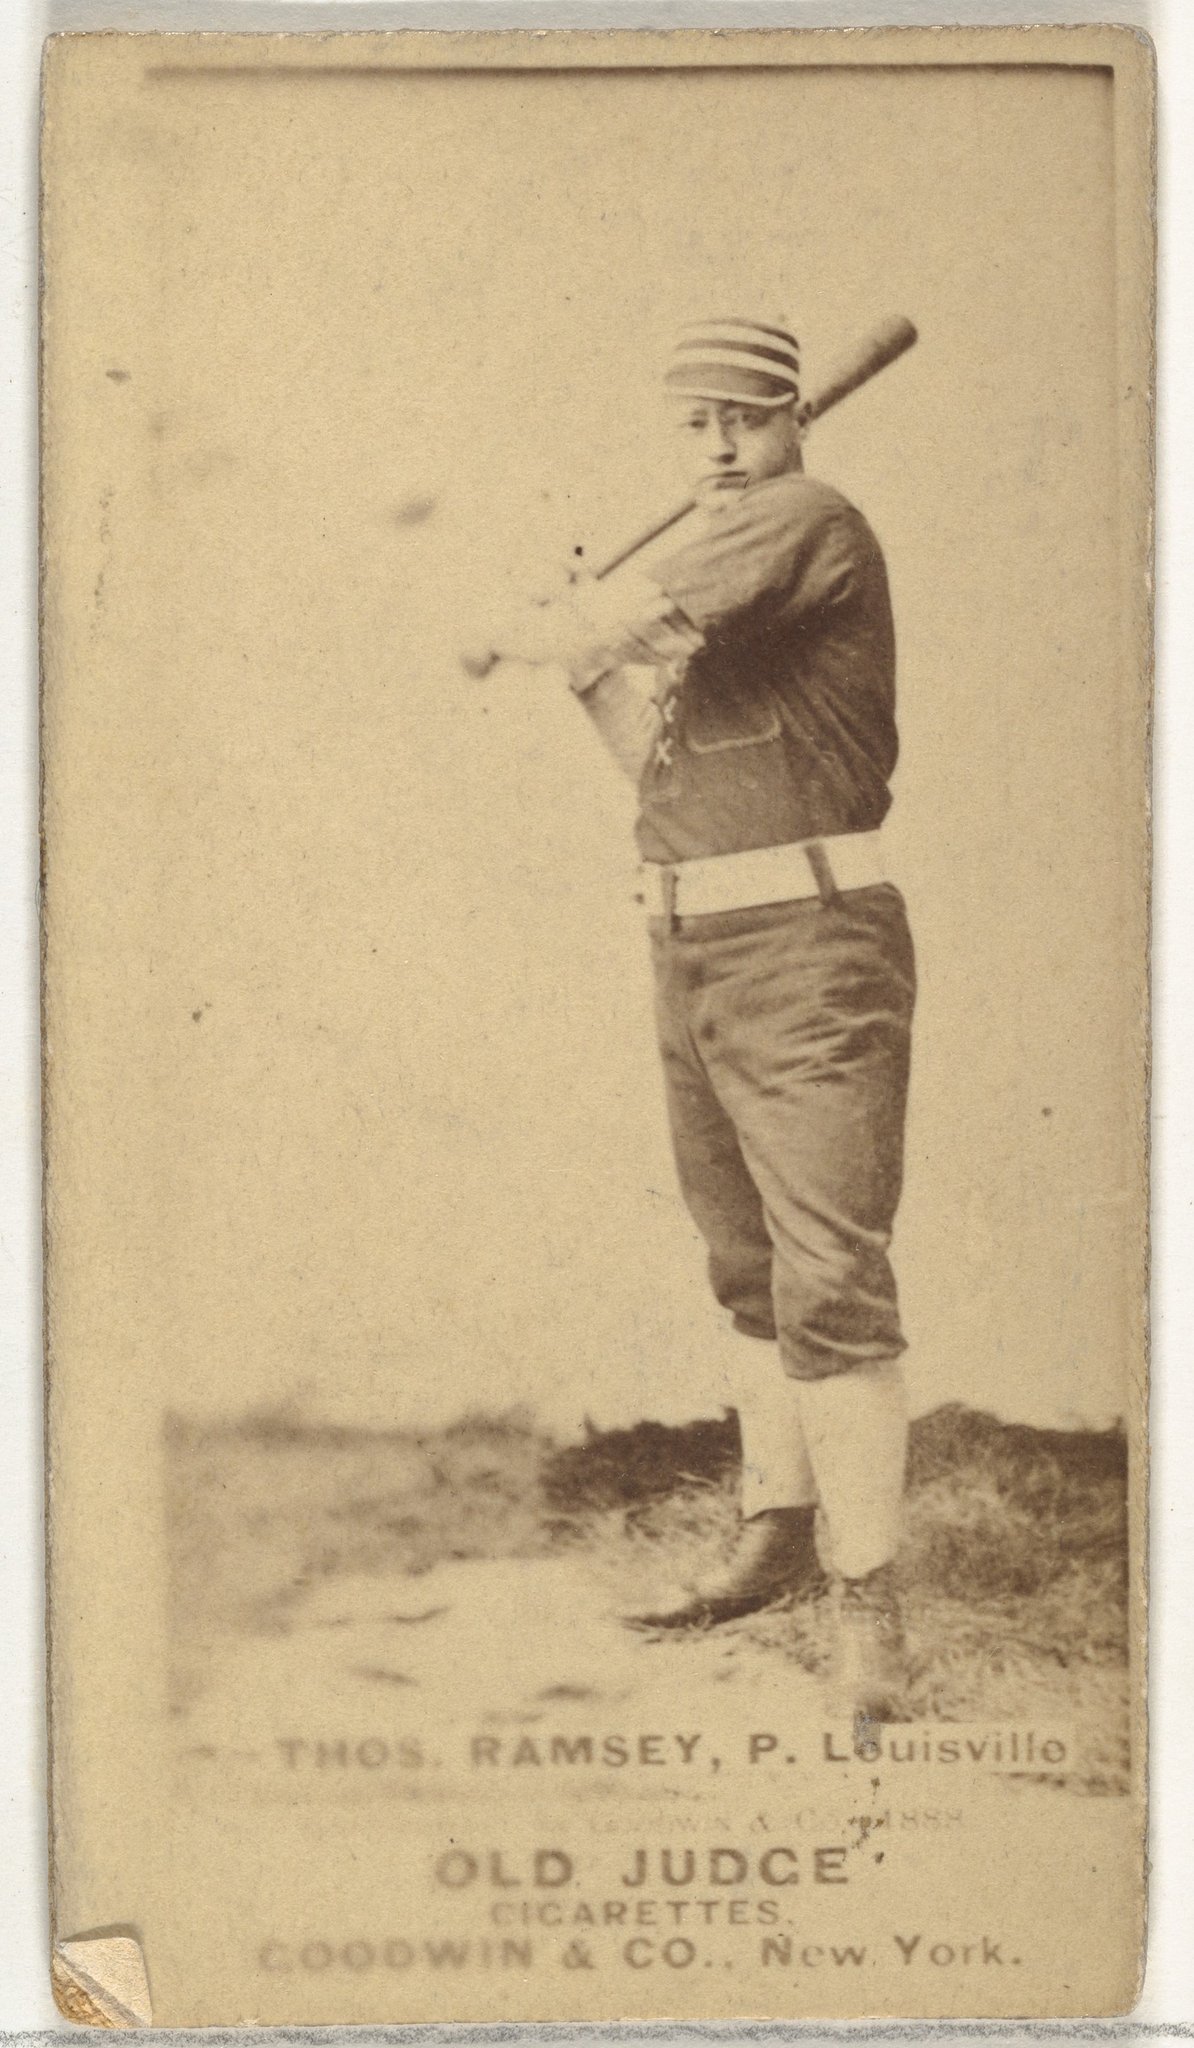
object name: baseball card, photograph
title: Thomas H. "Toad" Ramsey, Pitcher, Louisville Colonels, from the Old Judge series (N172) for Old Judge Cigarettes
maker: goodwin & company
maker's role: publisher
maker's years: 1850-1950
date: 1888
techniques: albumen silver print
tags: men,portraits,baseball,athletes